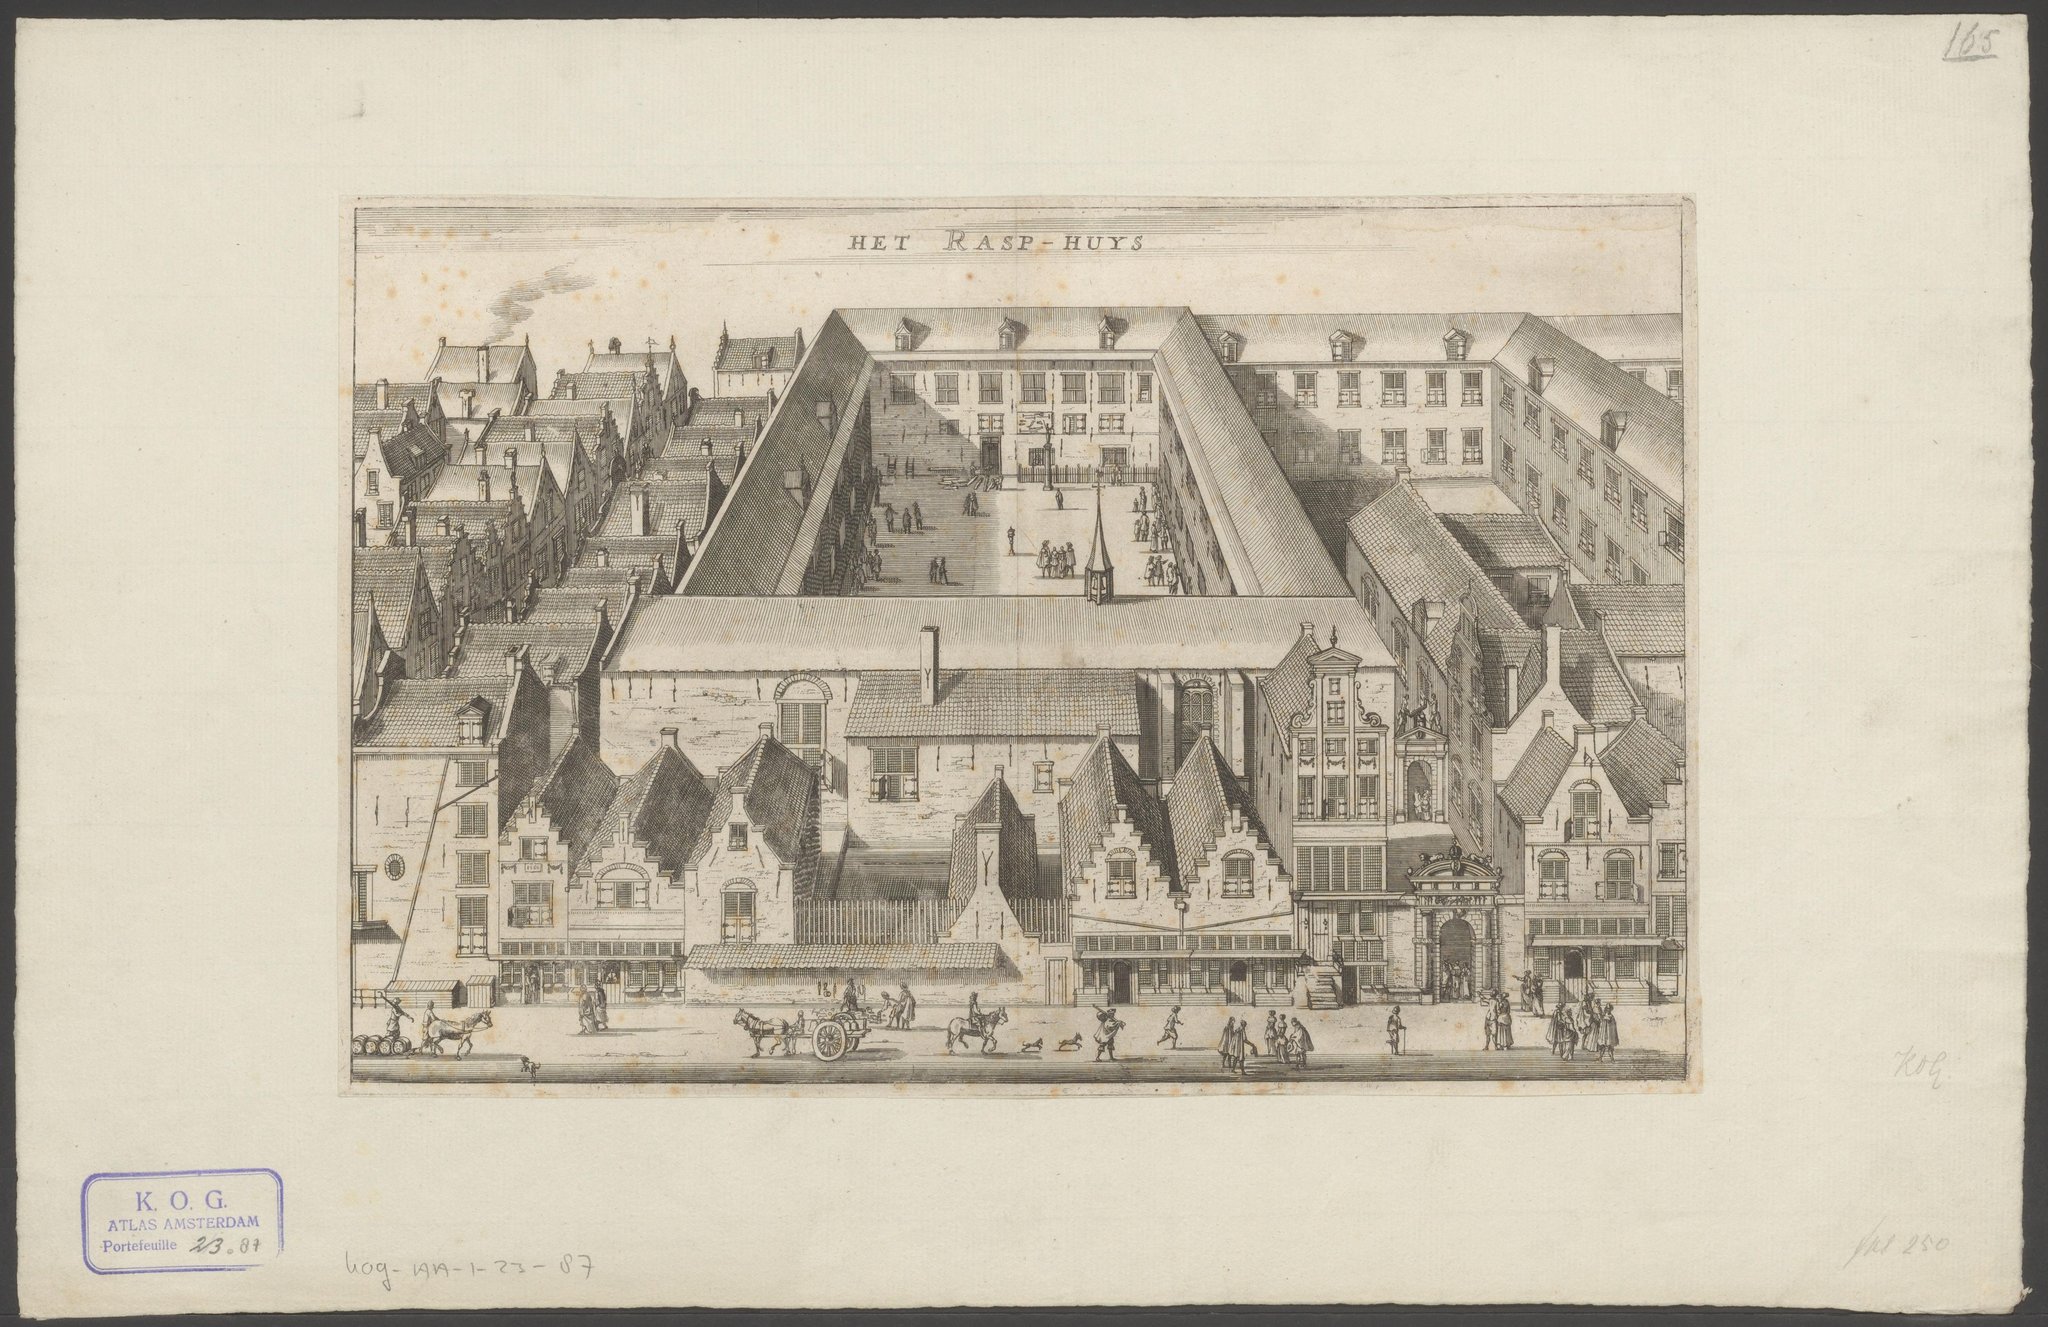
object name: book illustration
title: Gezicht op het Rasphuis te Amsterdam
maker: jacob van meurs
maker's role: draughtsman, print maker, publisher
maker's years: 1619-1680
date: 1663-1664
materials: paper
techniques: engraving, etching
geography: amsterdam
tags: prison, jail, (prisoners) in the prison yard, gate, entrance, workhouse, penal camp, penitentiary, chain gang, street (+ city(-scape) with figures, staffage)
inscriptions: collector's mark: Lugt 1641b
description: Prent mogelijk uit: Dapper, Olfert. Historische beschryving der stadt Amsterdam (…). Amsterdam: Jacob van Meurs, 1663. Of uit: Zesen, Philipp von. Beschreibung der Stadt Amsterdam (…). Amsterdam: Joachim Nosche, 1664. Bij sommige exemplaren van eerstgenoemde uitgave werd een latere staat ingebonden waarop boven de Nederlandse titel ook een Franse is toegevoegd.